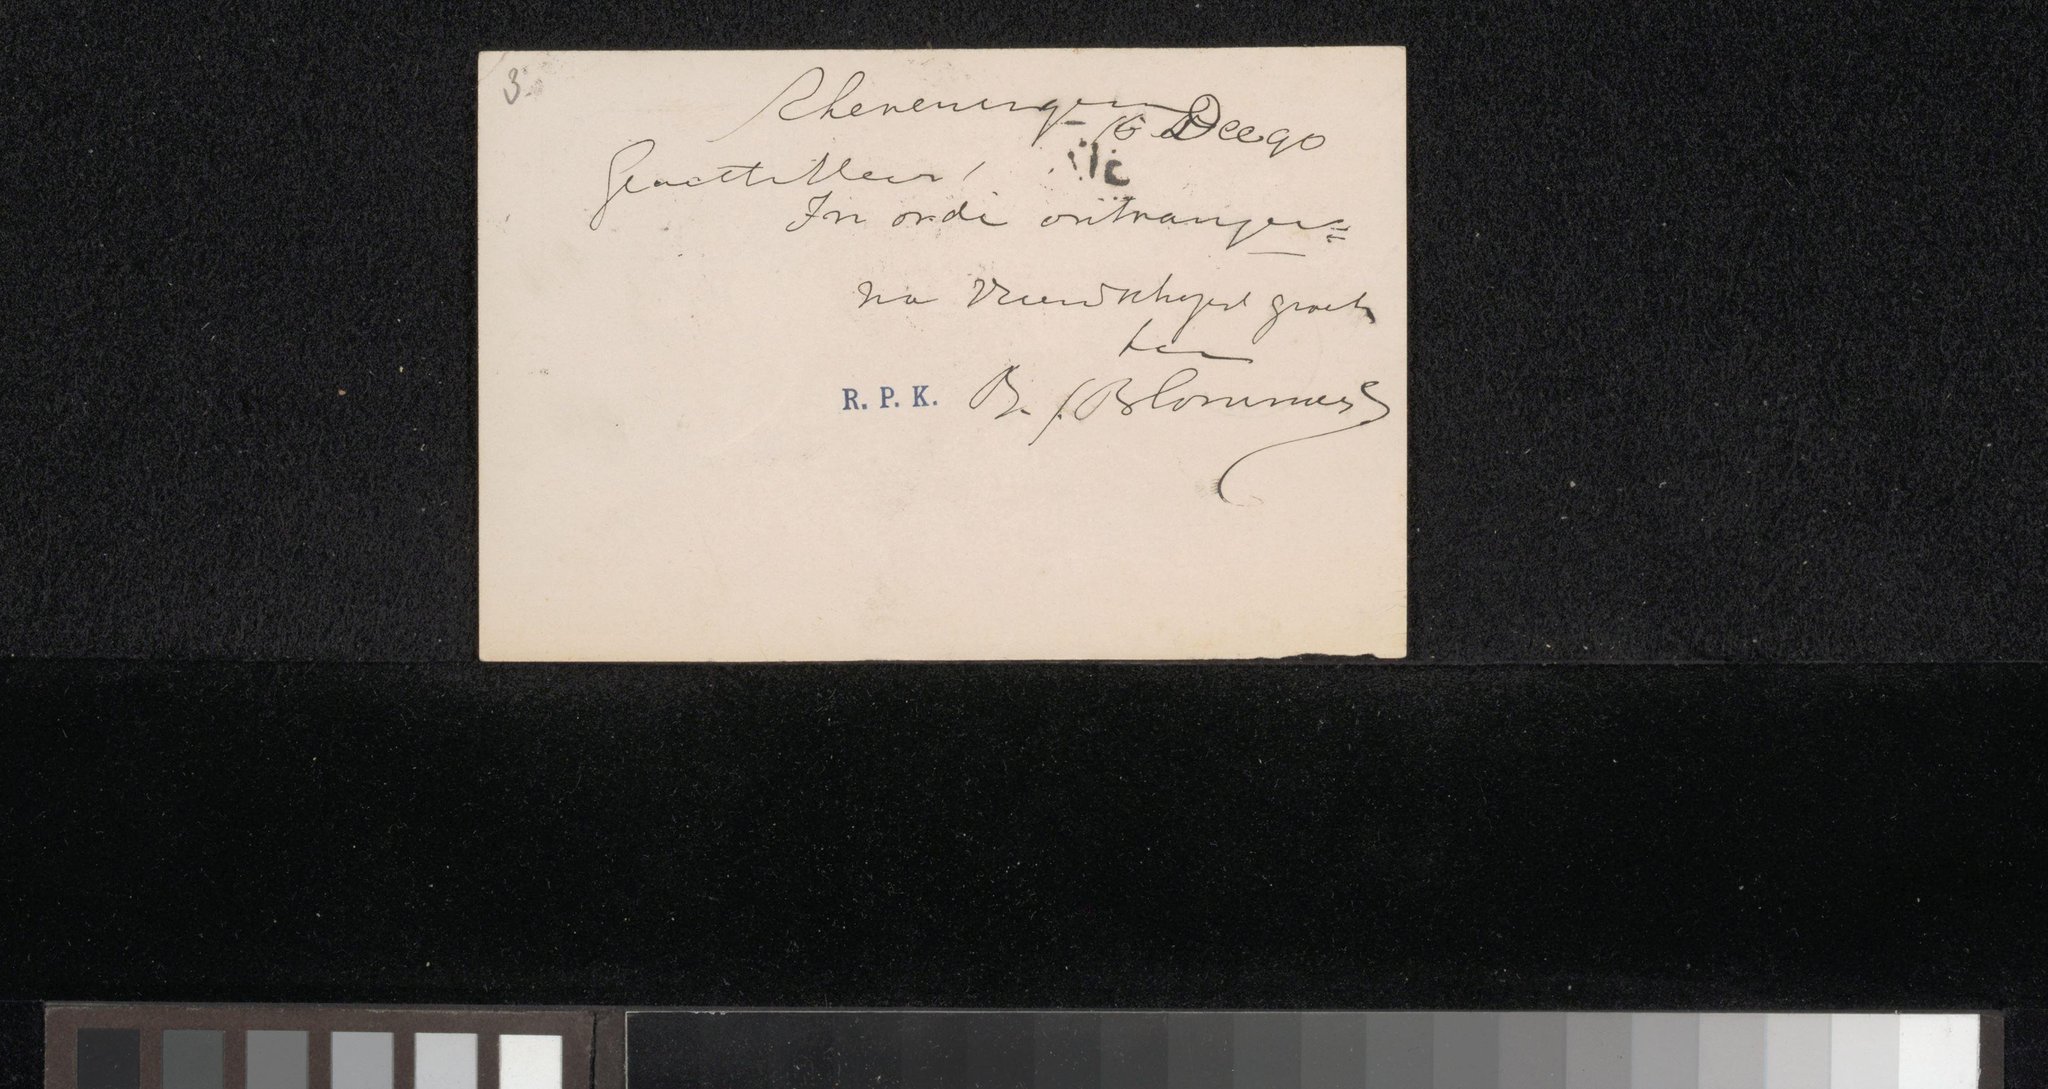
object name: postcard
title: Briefkaart aan Frans Buffa en Zonen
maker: bernardus johannes blommers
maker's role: draughtsman, print maker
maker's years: 1845-1914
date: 1890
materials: cardboard, ink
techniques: pen, writing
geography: scheveningen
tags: publisher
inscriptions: collector's mark: Lugt 2233